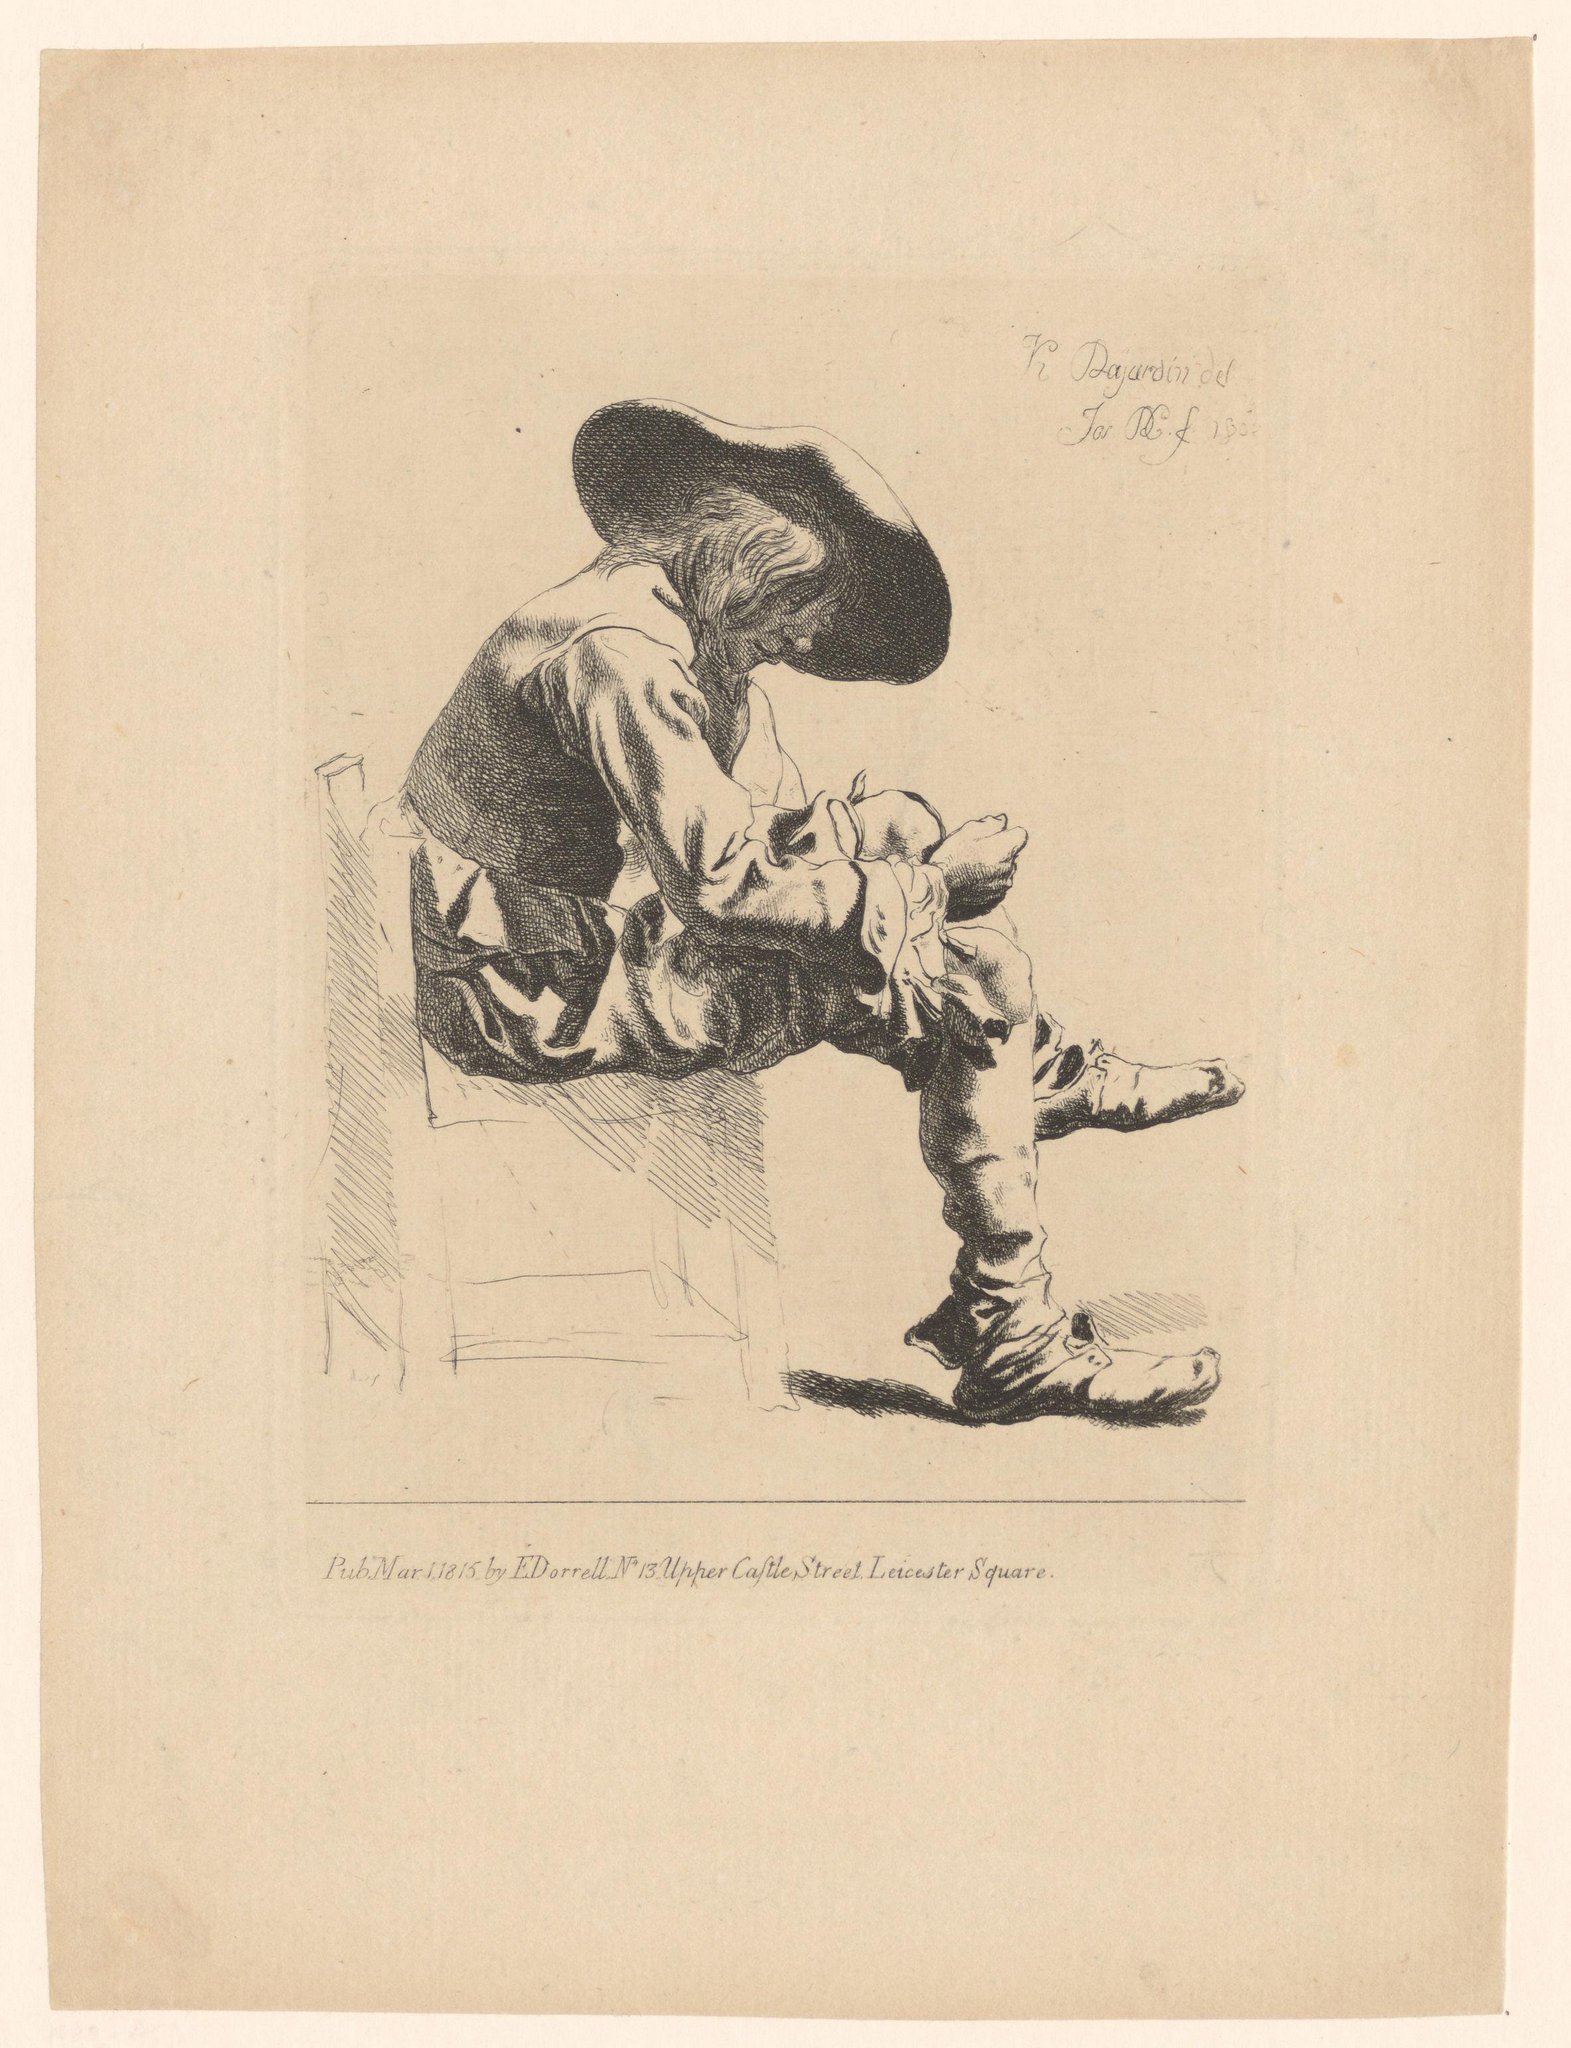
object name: print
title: Zittende man met hoed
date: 1802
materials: paper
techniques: etching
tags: sitting figure, head-gear: hat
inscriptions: signature and date: ‘K. Dujardin del./ Jos DC f. 1802’, : ‘Pub. Mar. 1815 by E. Dorrell, No 13 Upper Castle Street, Leicester Square’, collector's mark: Lugt 2228